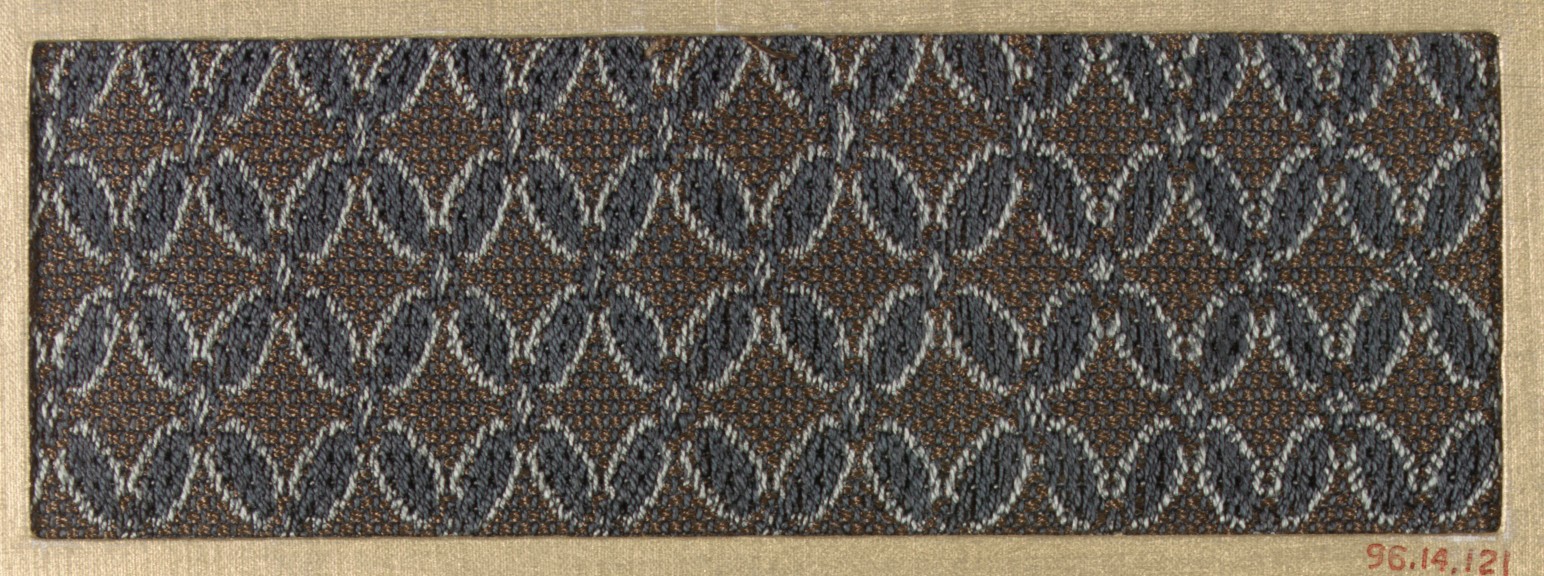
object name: piece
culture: japanese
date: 1701-1900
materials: silk